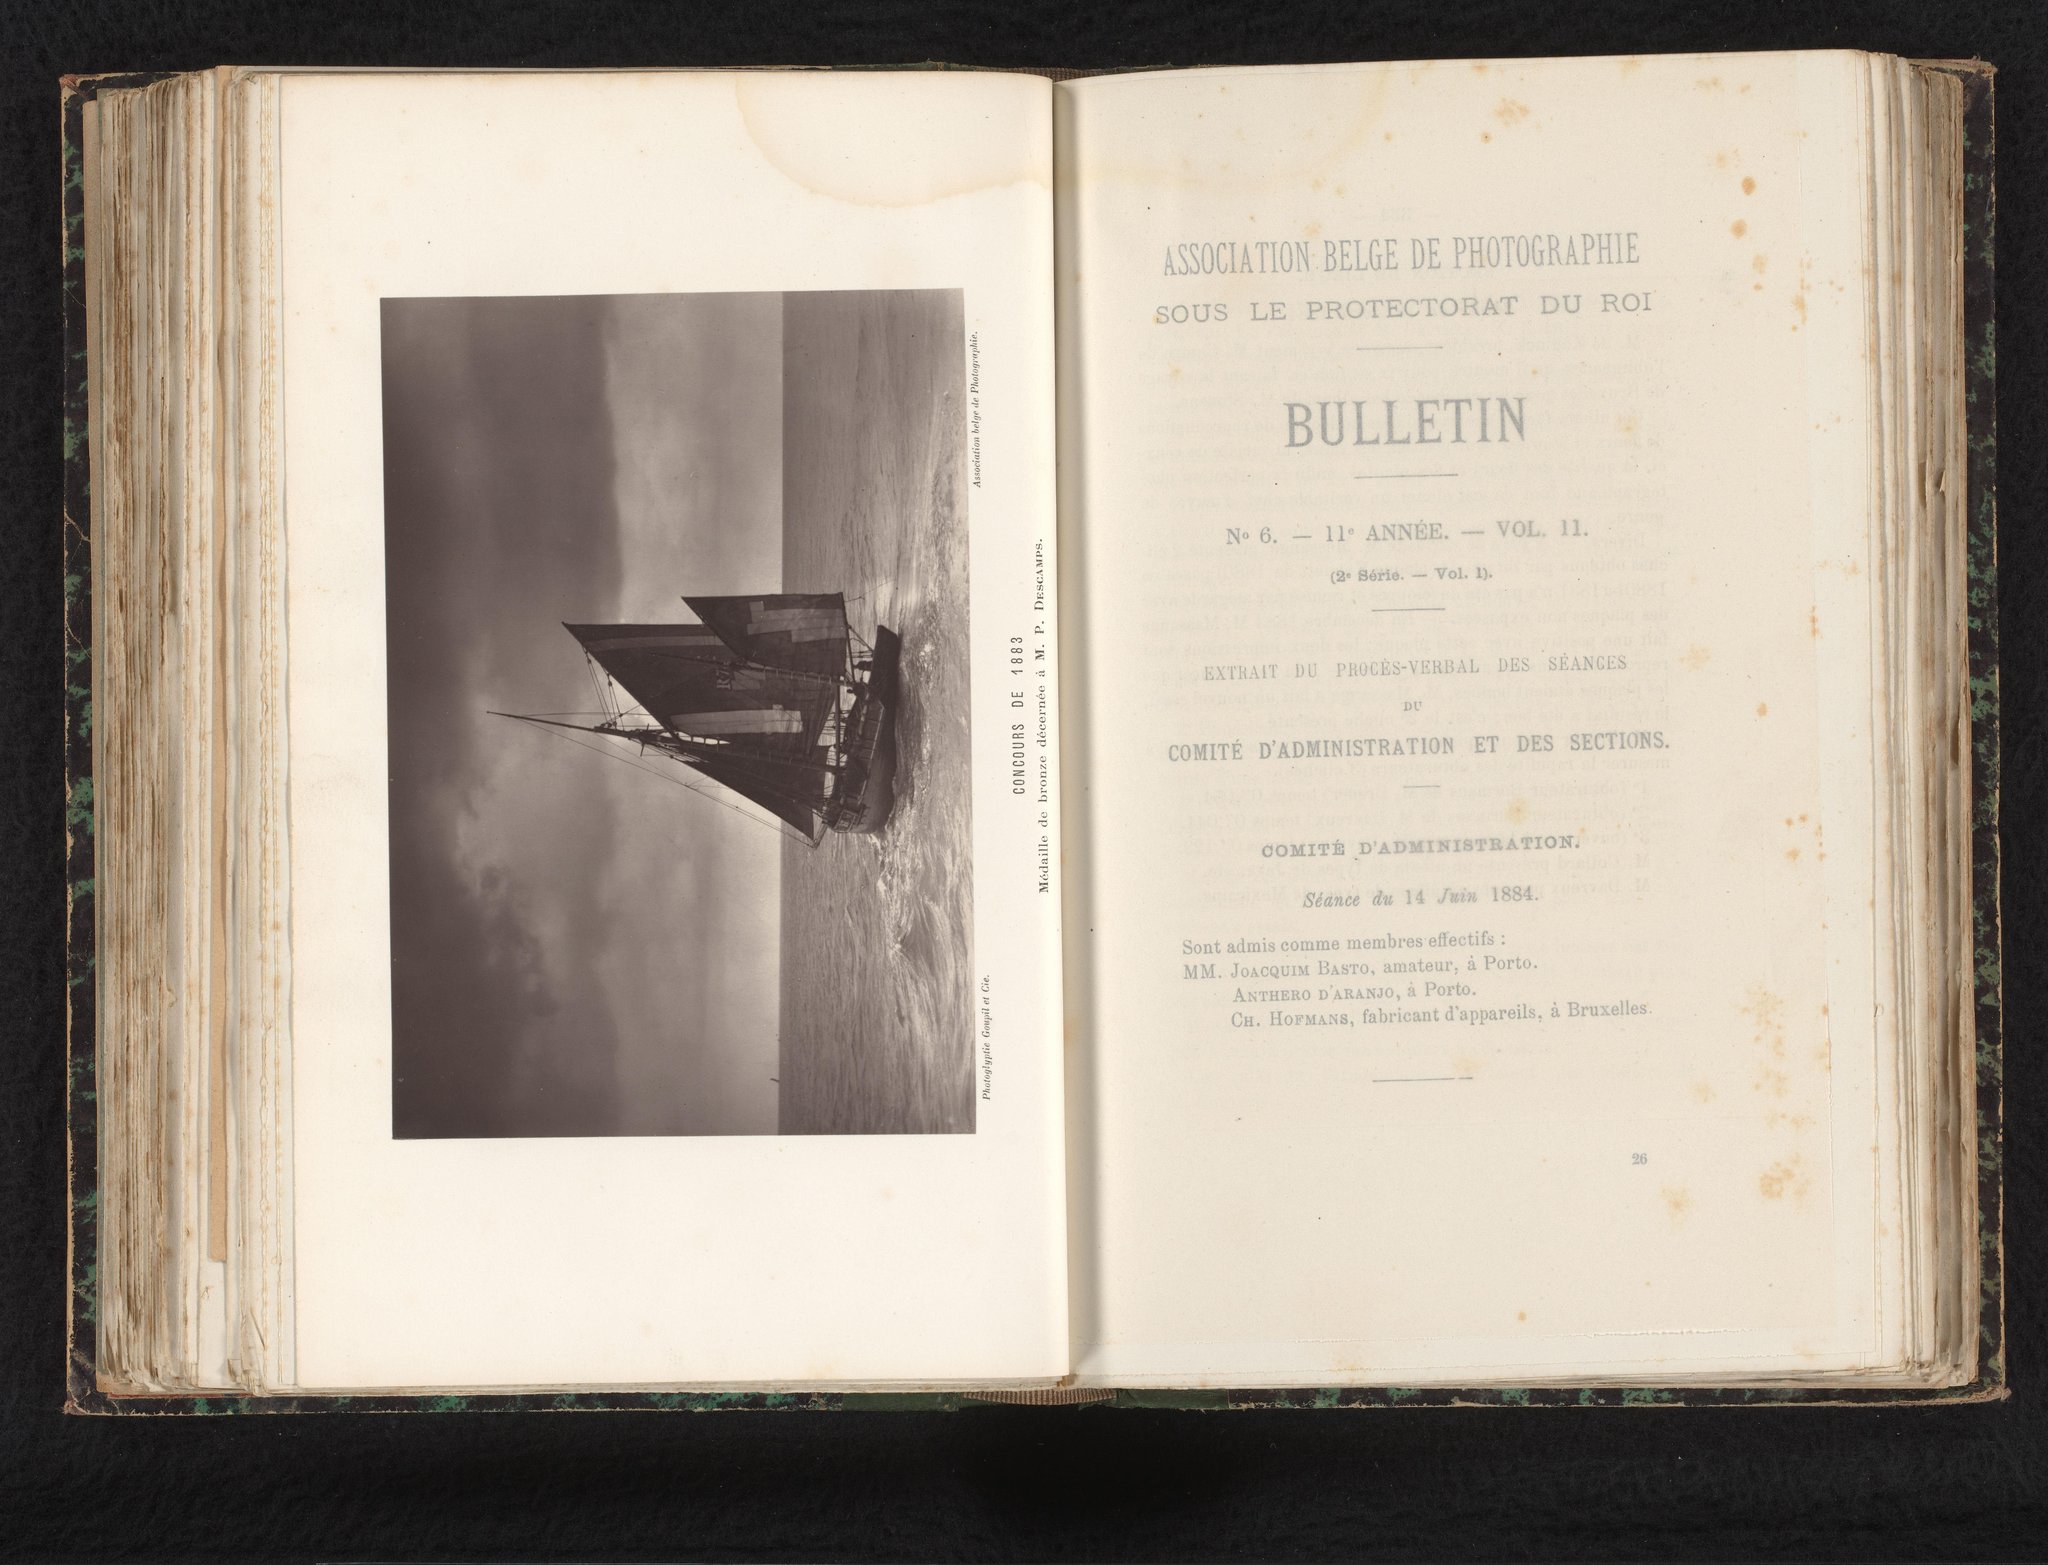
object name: page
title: Zeilschepen op zee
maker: palmer descamps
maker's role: goldsmith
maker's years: 1840-1884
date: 1878-1883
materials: paper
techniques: woodburytype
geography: paris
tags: sailing-ship, sailing-boat, sea (seascape)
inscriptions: inscription: ‘Concours de 1883/ Médaille de bronze décernée à M. P. Descamps.’